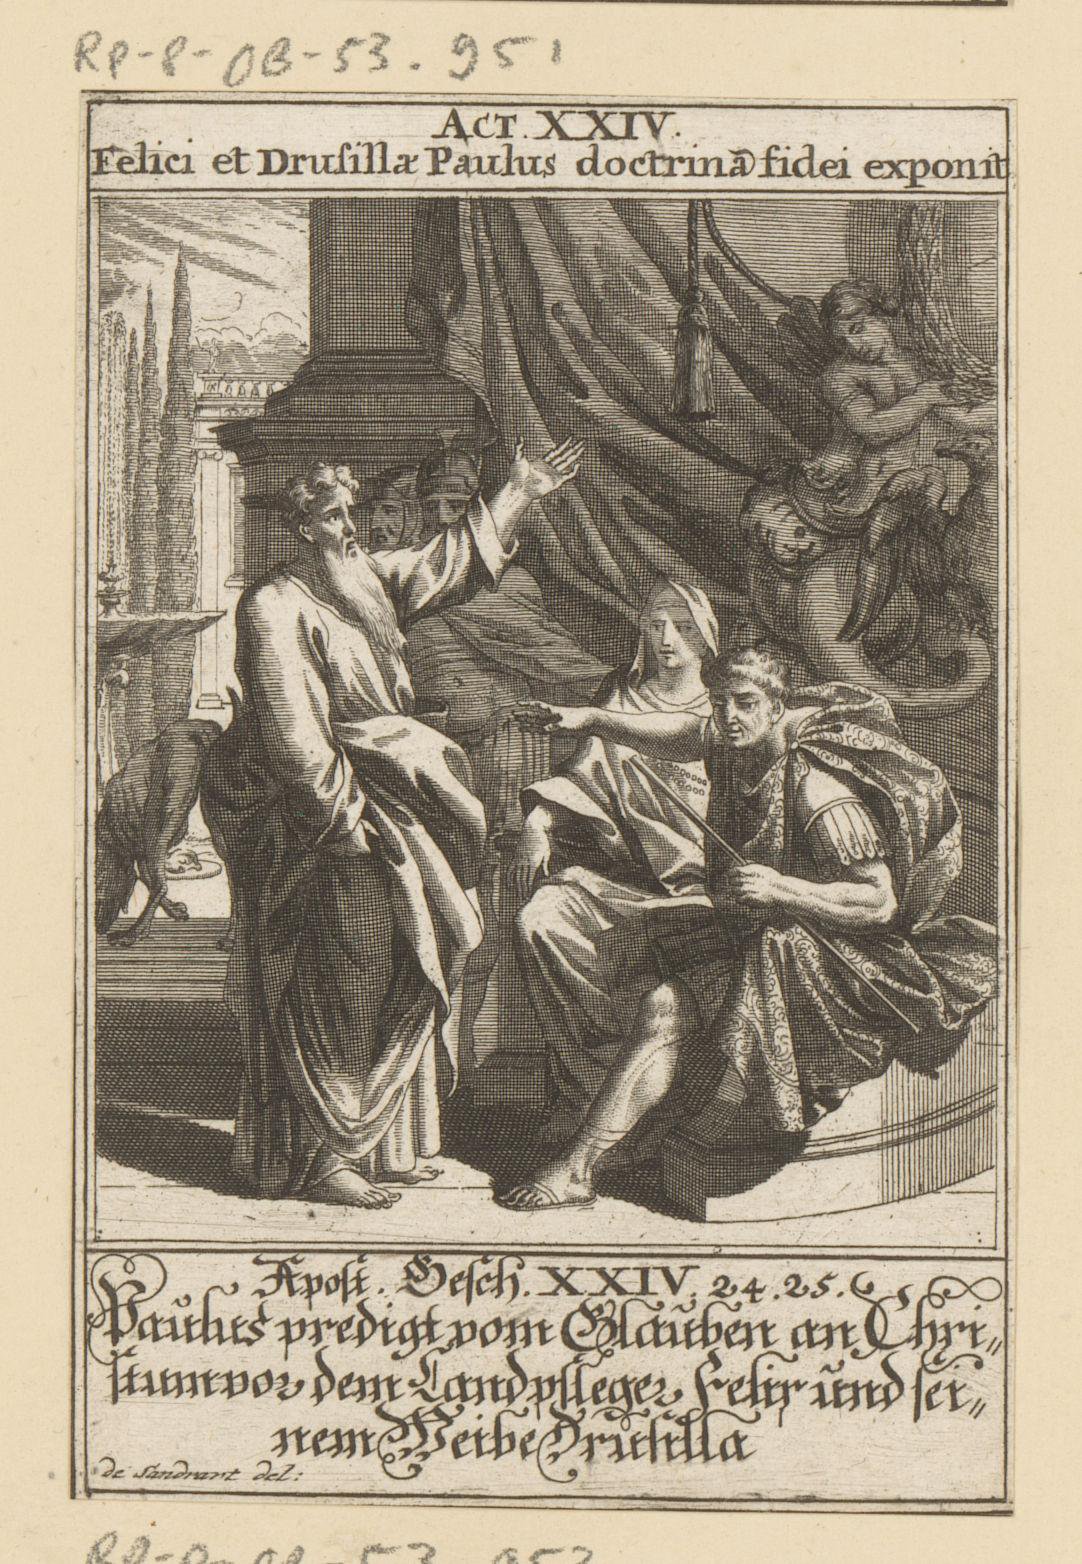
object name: print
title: Apostel Paulus voor Felix en Drusilla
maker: Anonymous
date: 1697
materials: paper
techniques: etching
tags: paul before felix and drusilla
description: Prent ook gebruikt in: Biblia ectypa : Bildnussen auss Heiliger Schrifft. Regensburg: Chr. Wiegel, 1697.